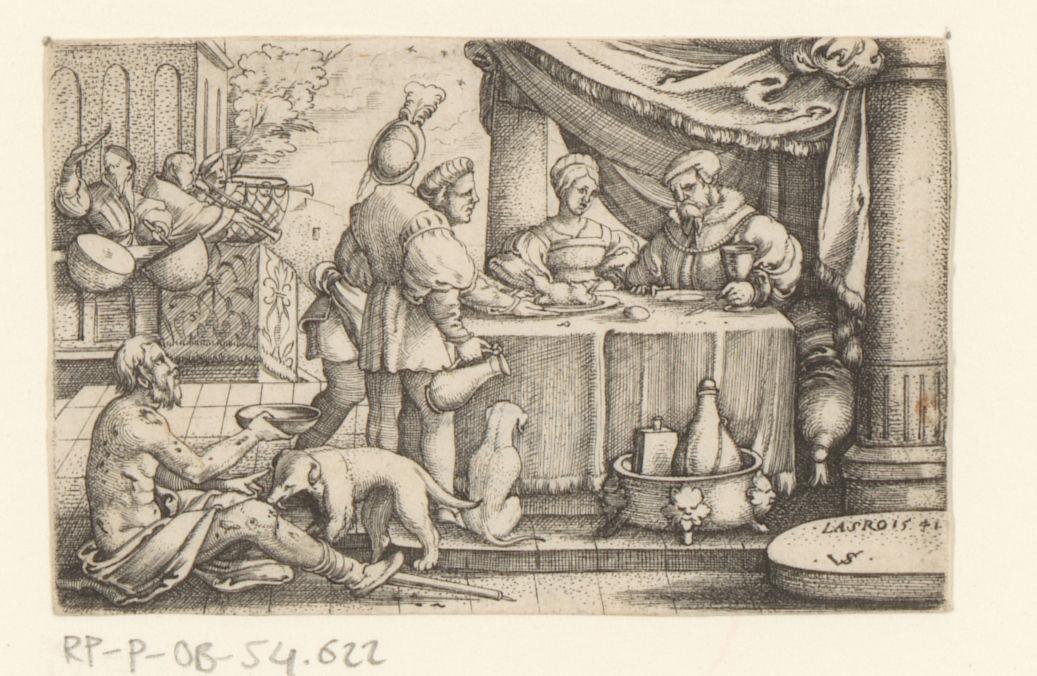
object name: print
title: Rijke man en de arme Lazarus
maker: virgilius solis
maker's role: draughtsman, print maker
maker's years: 1514-1562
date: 1541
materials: paper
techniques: engraving, etching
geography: nuremberg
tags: the rich man (dives) is feasting, while poor lazarus is starving at the gate (dogs licking lazarus' sores) (luke 16:19-31)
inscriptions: collector's mark: Lugt 2228, number: ‘74’